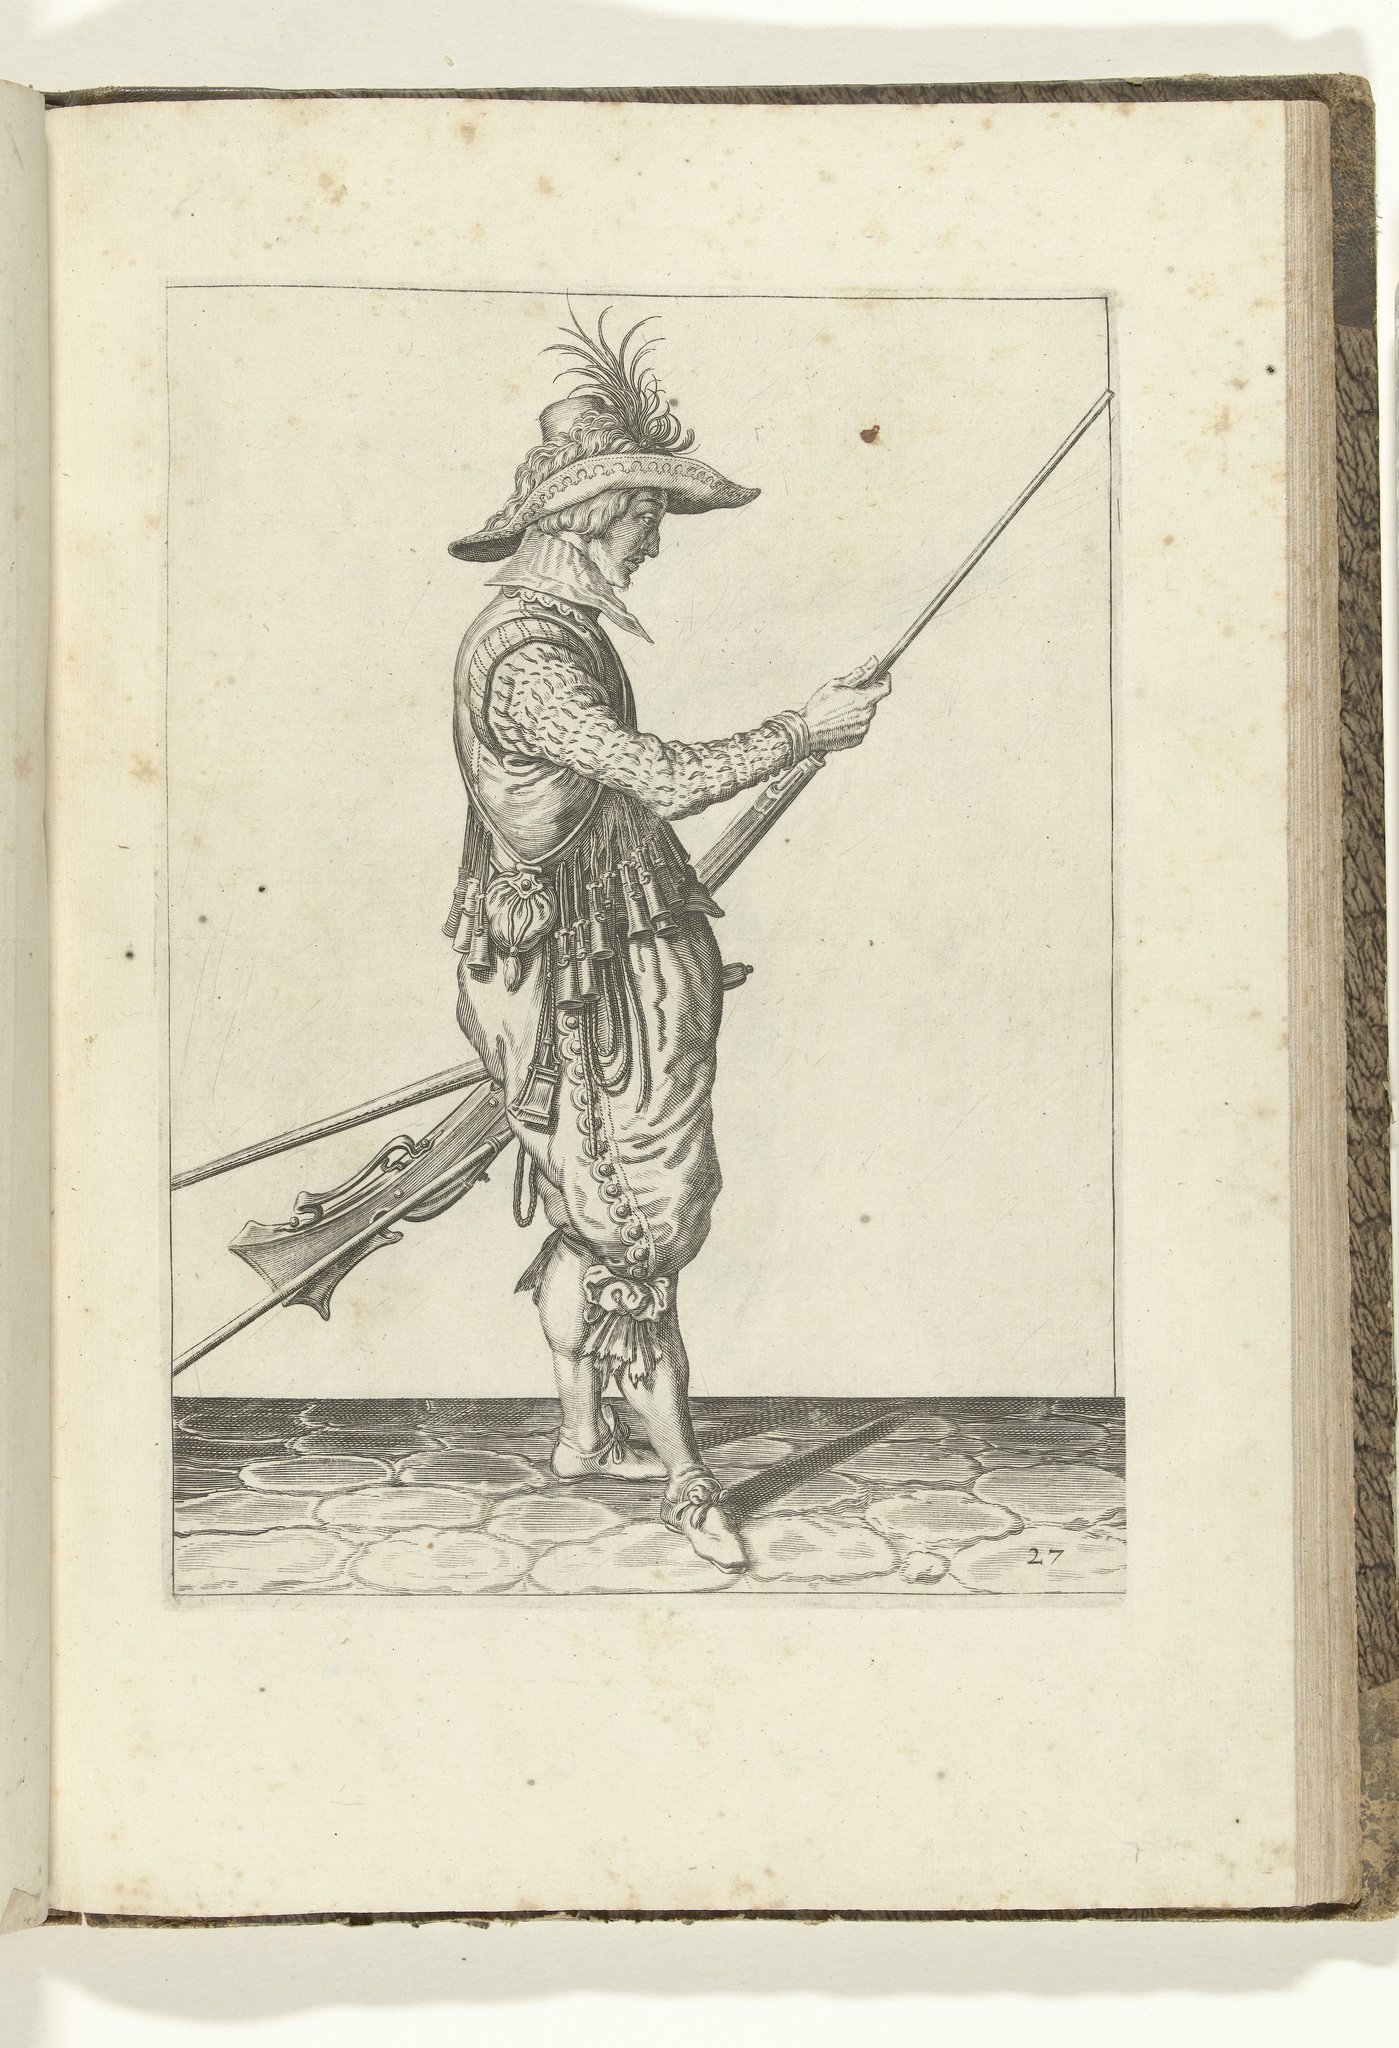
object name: print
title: Soldaat die met zijn laadstok kruit en kogel in de loop van zijn musket duwt (nr. 27), ca. 1600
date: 1597-1608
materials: paper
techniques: engraving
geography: northern netherlands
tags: maurice (prince of orange), handling of weapons ~ military training, weapons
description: Een soldaat, ten voeten uit, naar rechts, die met zijn linkerhand bij zijn linkerdijbeen een musket (een bepaald type vuurwapen) vasthoudt en met zijn rechterhand zijn laadstok in de loop brengt, om kruit en kogel aan te duwen (nr. 27), ca. 1600. In zijn linkerhand behalve het musket ook een furket (musketvork) en een lont. Plaat 27 in de instructies voor het hanteren van het musket: Brief enseignement, sur les pourtraitz figurez, touchant le droit maniement du Mousquet. Onderdeel van de illustraties in een Franse editie van J. de Gheyns Wapenhandelinghe: J. de Gheyn, Maniement d'armes, d'arquebuses, mousquetz et piques : en conformité de l'ordre de Mour le Prince Maurice, Prince d'Orange, Amsterdam 1608. Krijgswezen rond 1600.